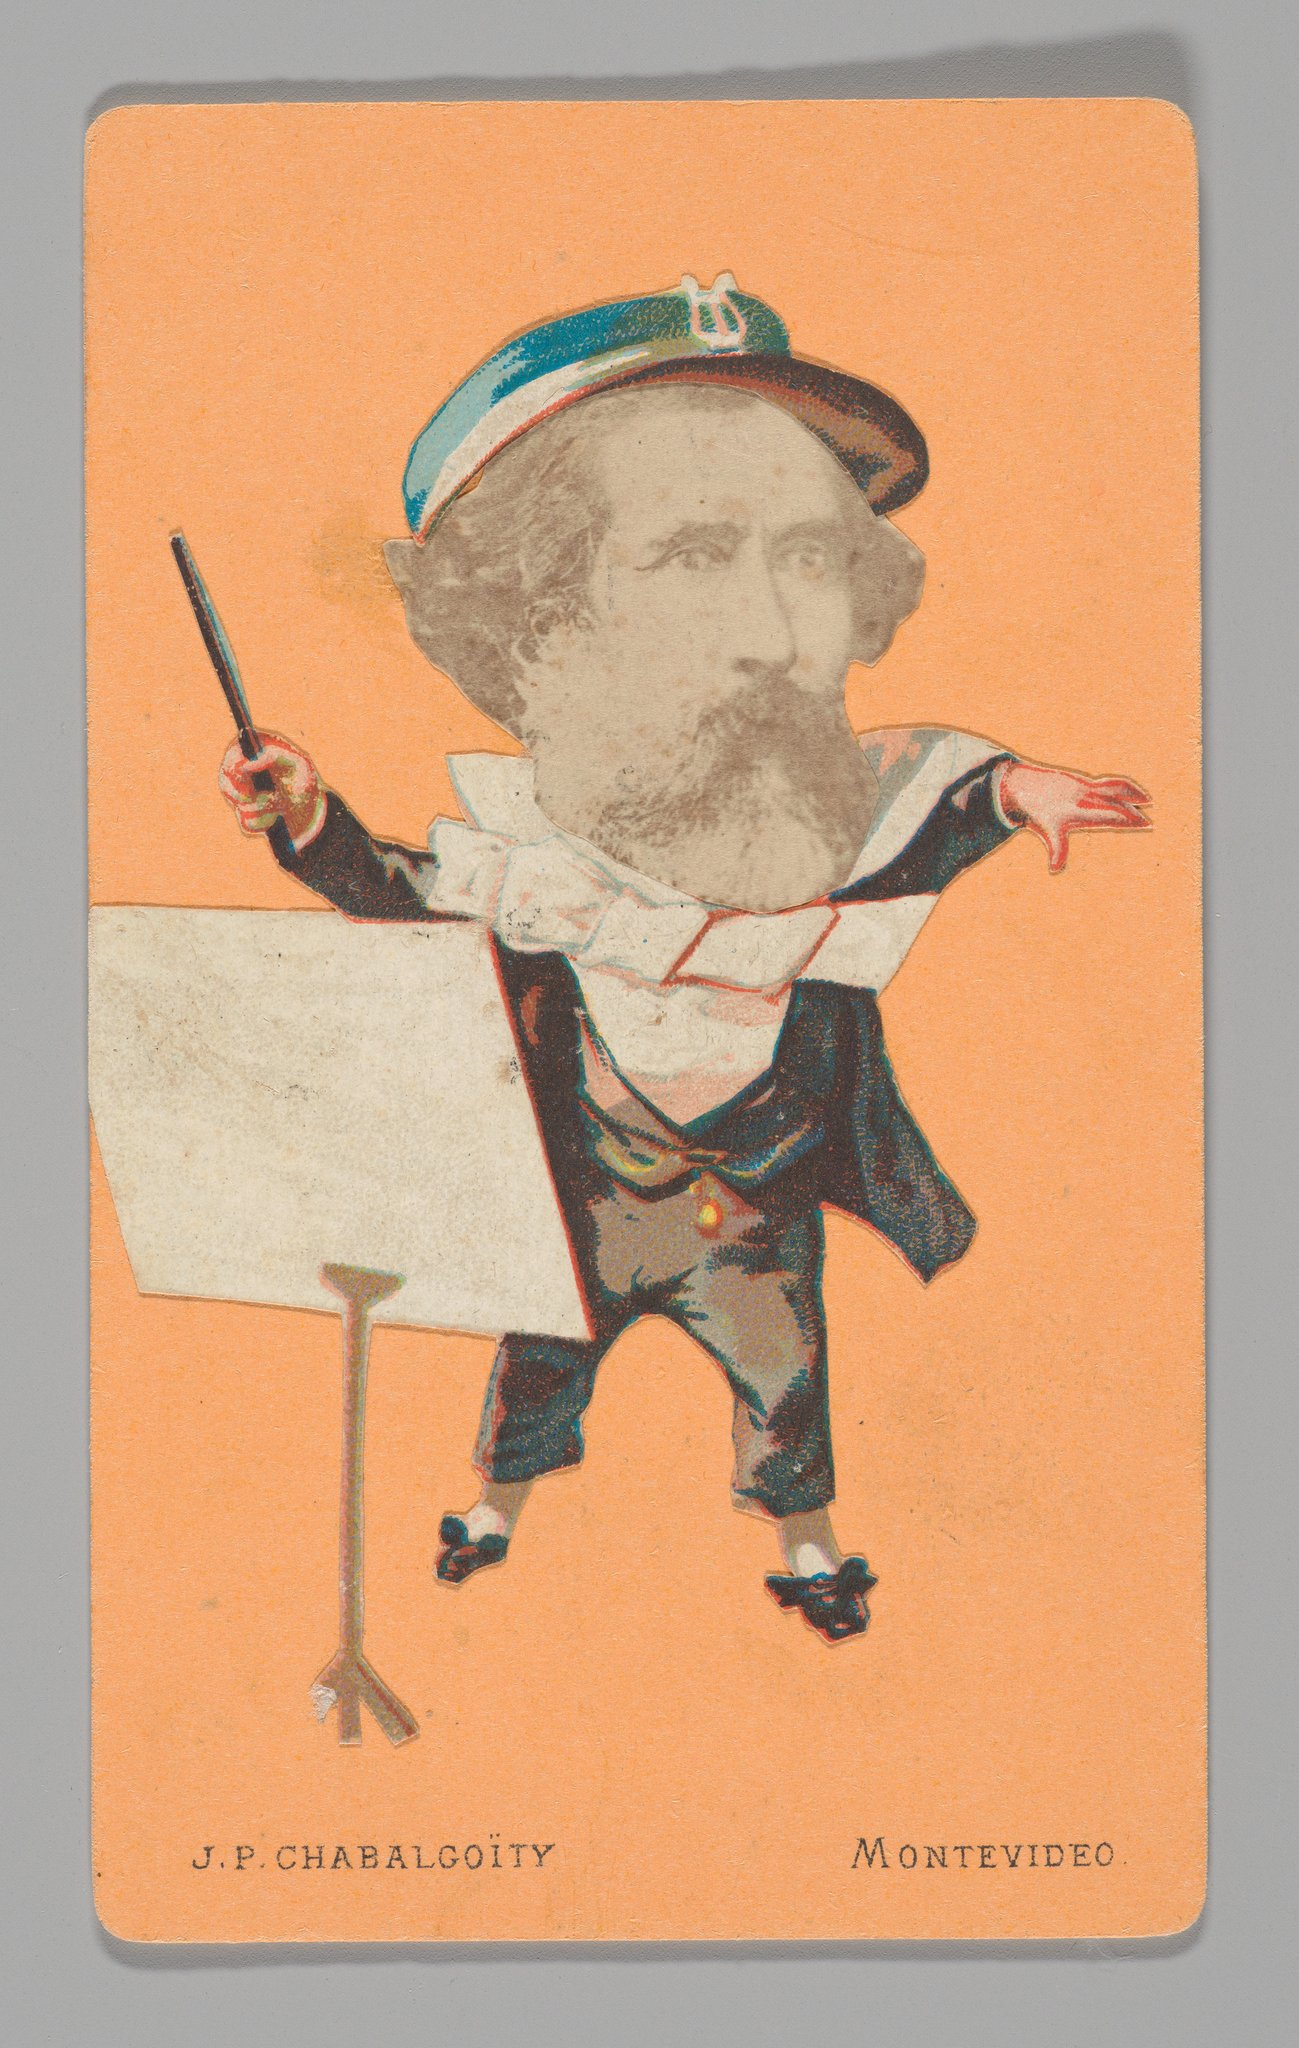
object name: carte de visite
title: [Photo Collage: Musical Conductor]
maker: juan pedro chabalgoity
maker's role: artist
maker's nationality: uruguayan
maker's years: 1848-1909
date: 1875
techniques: albumen silver print, lithograph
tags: men,musicians